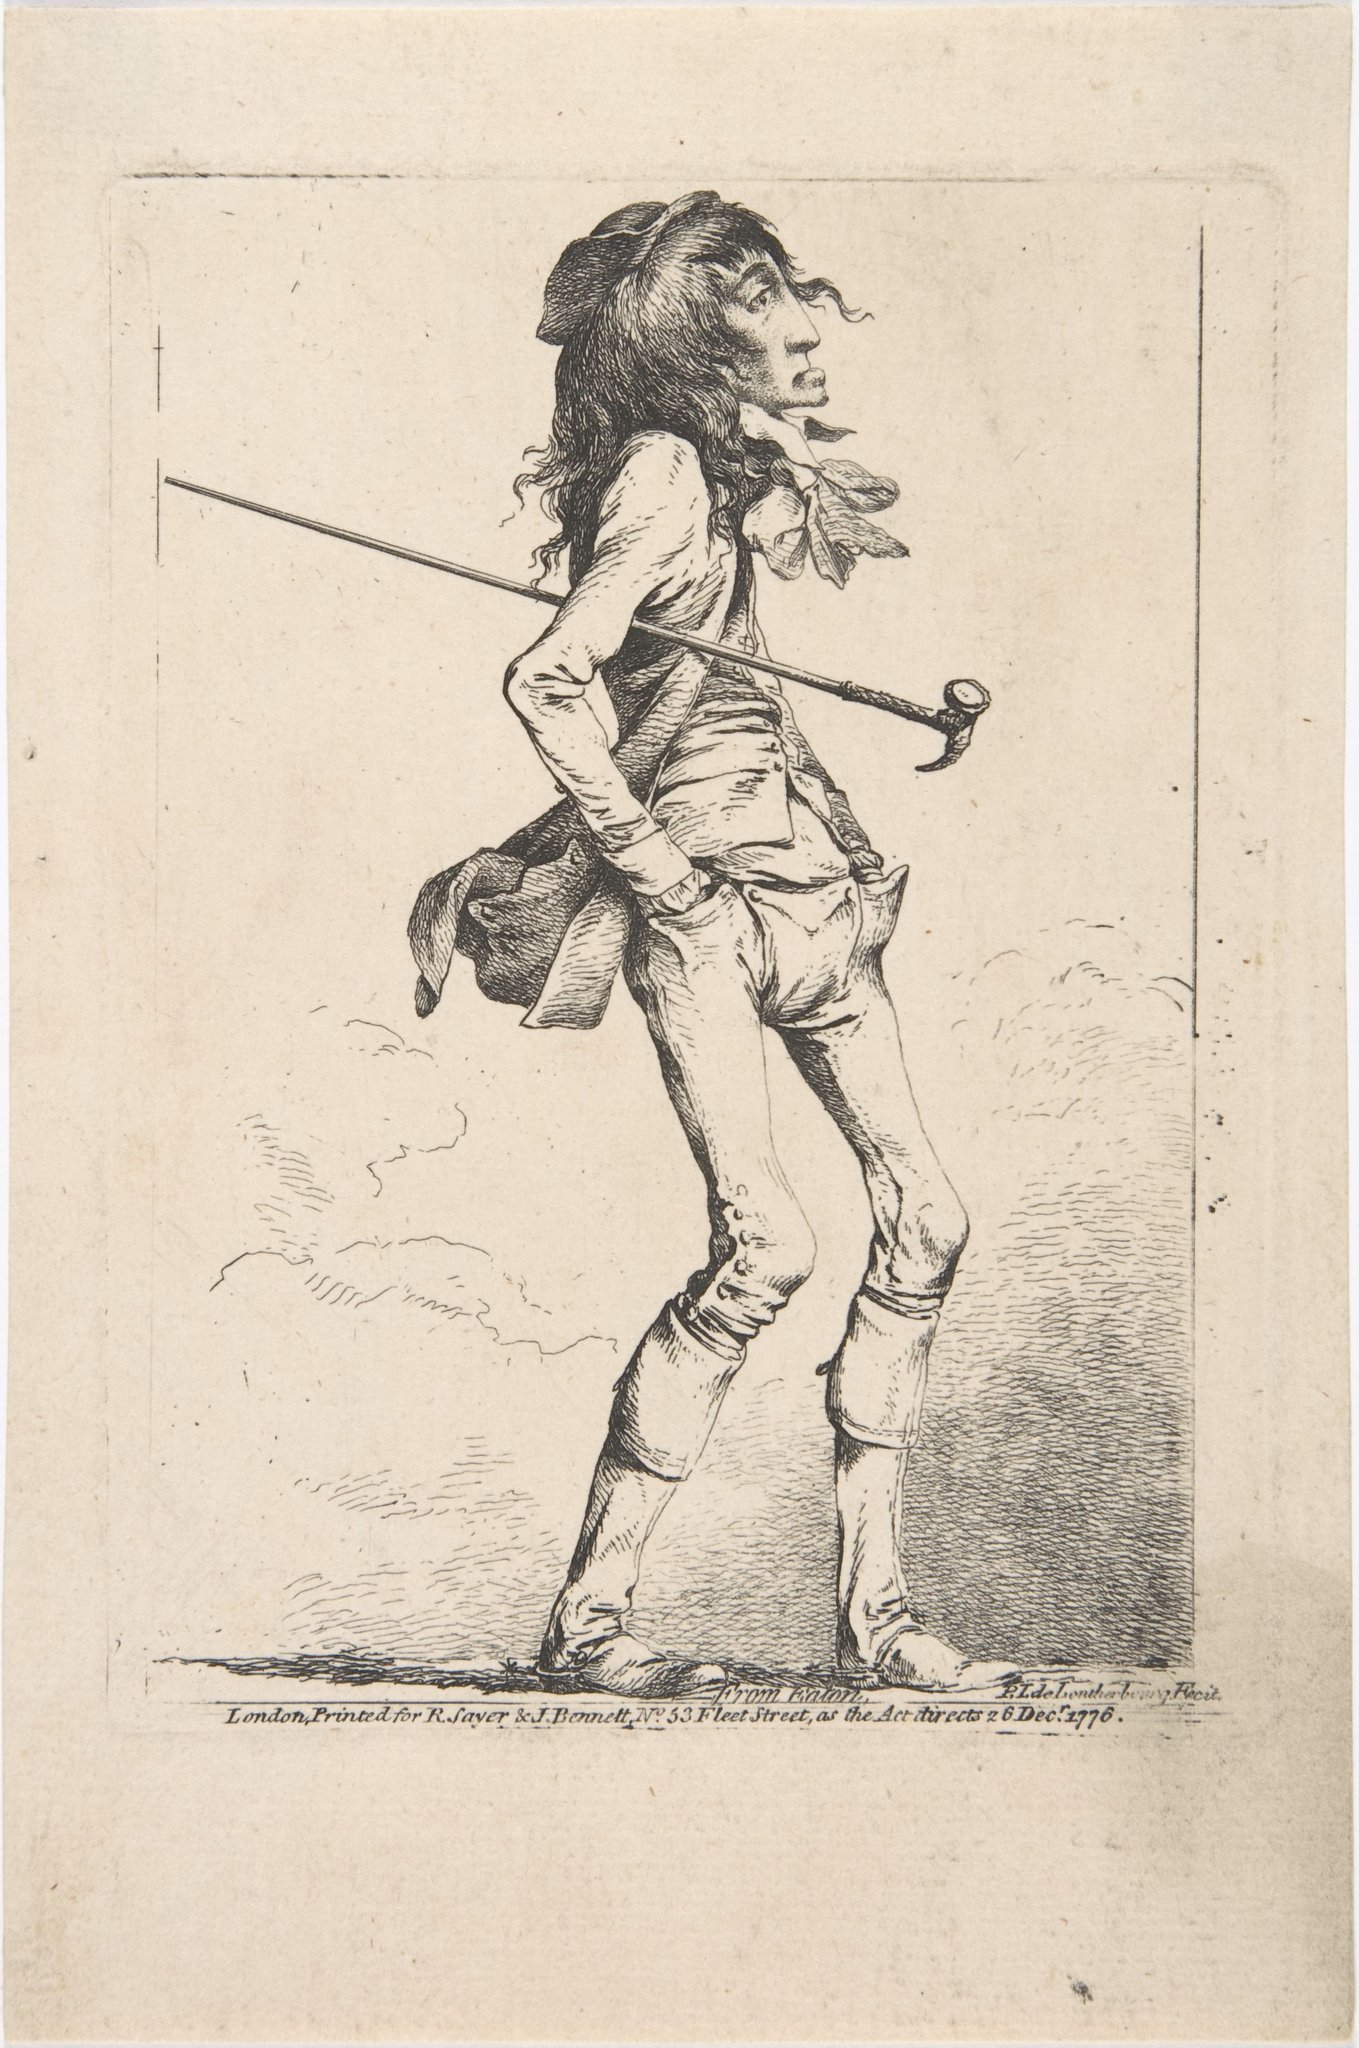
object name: print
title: From Eaton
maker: philippe jacques de loutherbourg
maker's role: artist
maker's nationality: french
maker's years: 1740-1812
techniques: etching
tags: men